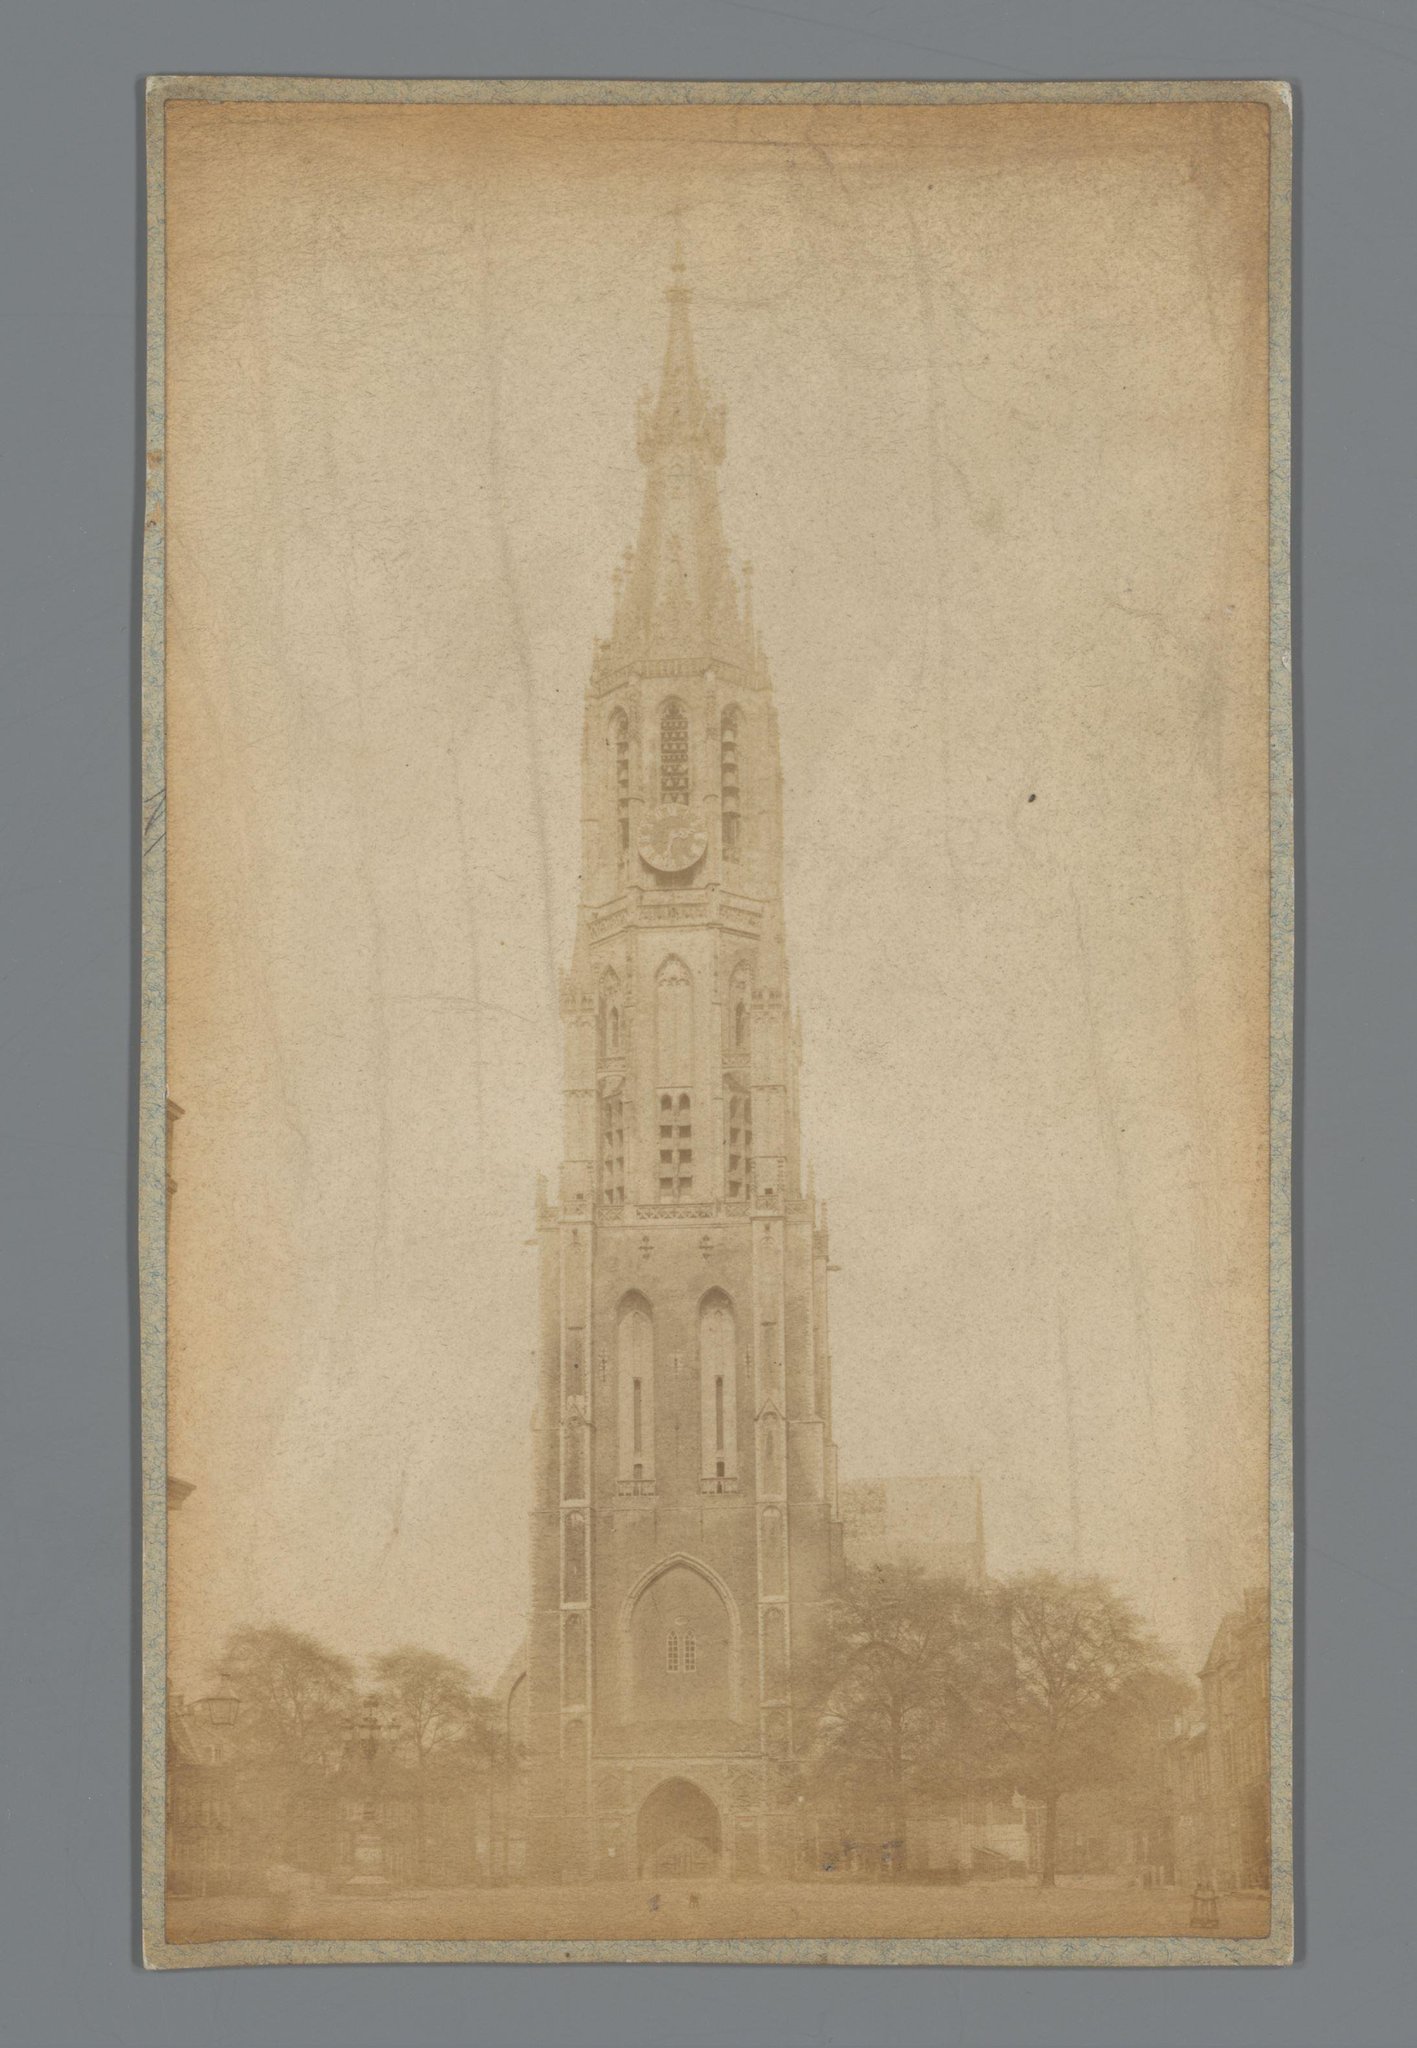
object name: photograph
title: Toren van de Nieuwe Kerk te Delft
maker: Anonymous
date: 1870-1890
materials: cardboard, photographic support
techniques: albumen print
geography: delft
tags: parts of church exterior and annexes: tower